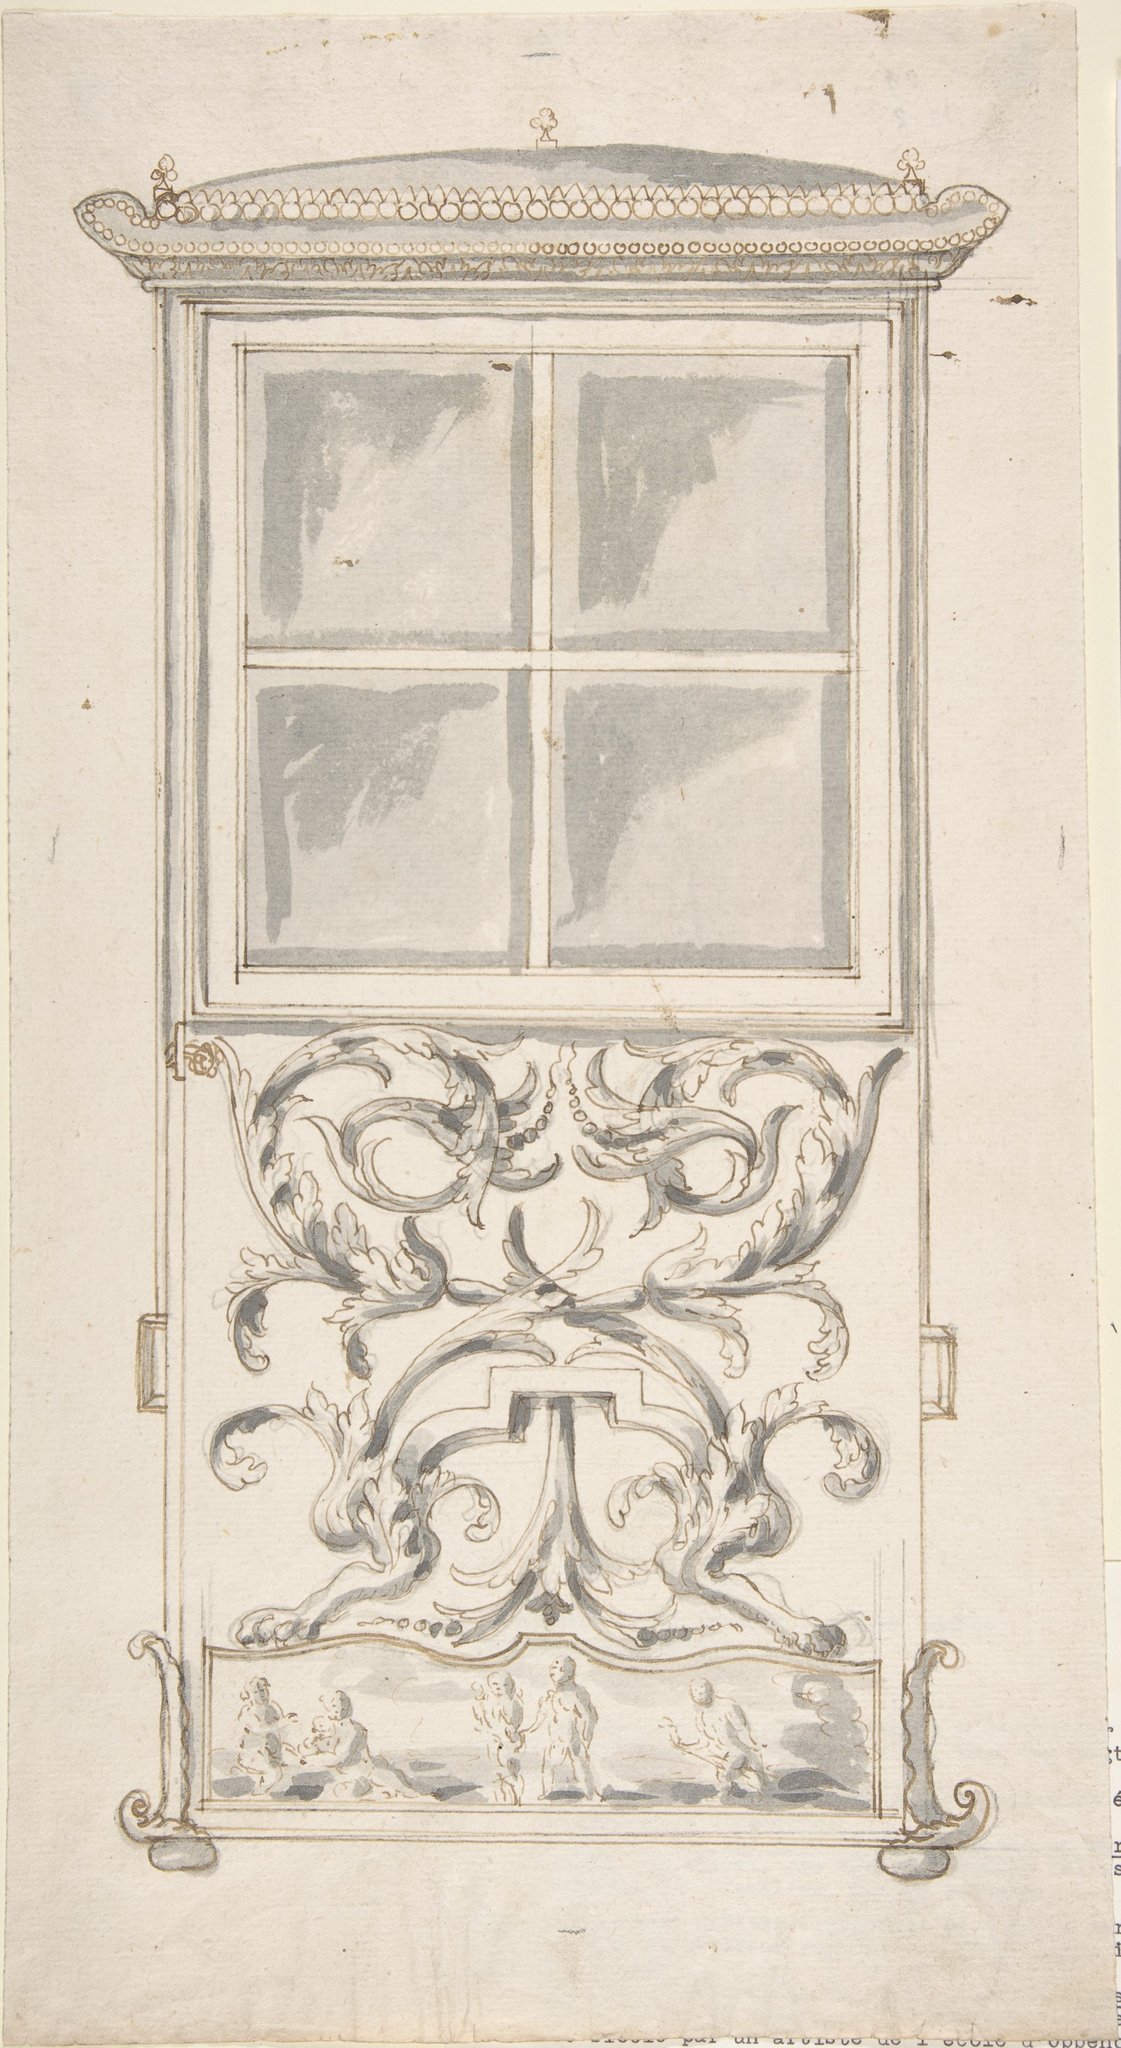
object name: drawing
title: Design for a Sedan Chair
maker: anonymous, french, 18th century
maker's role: artist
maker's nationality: french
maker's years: 1700-1800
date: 1700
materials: graphite, ink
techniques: brush, pen, wash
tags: ornament